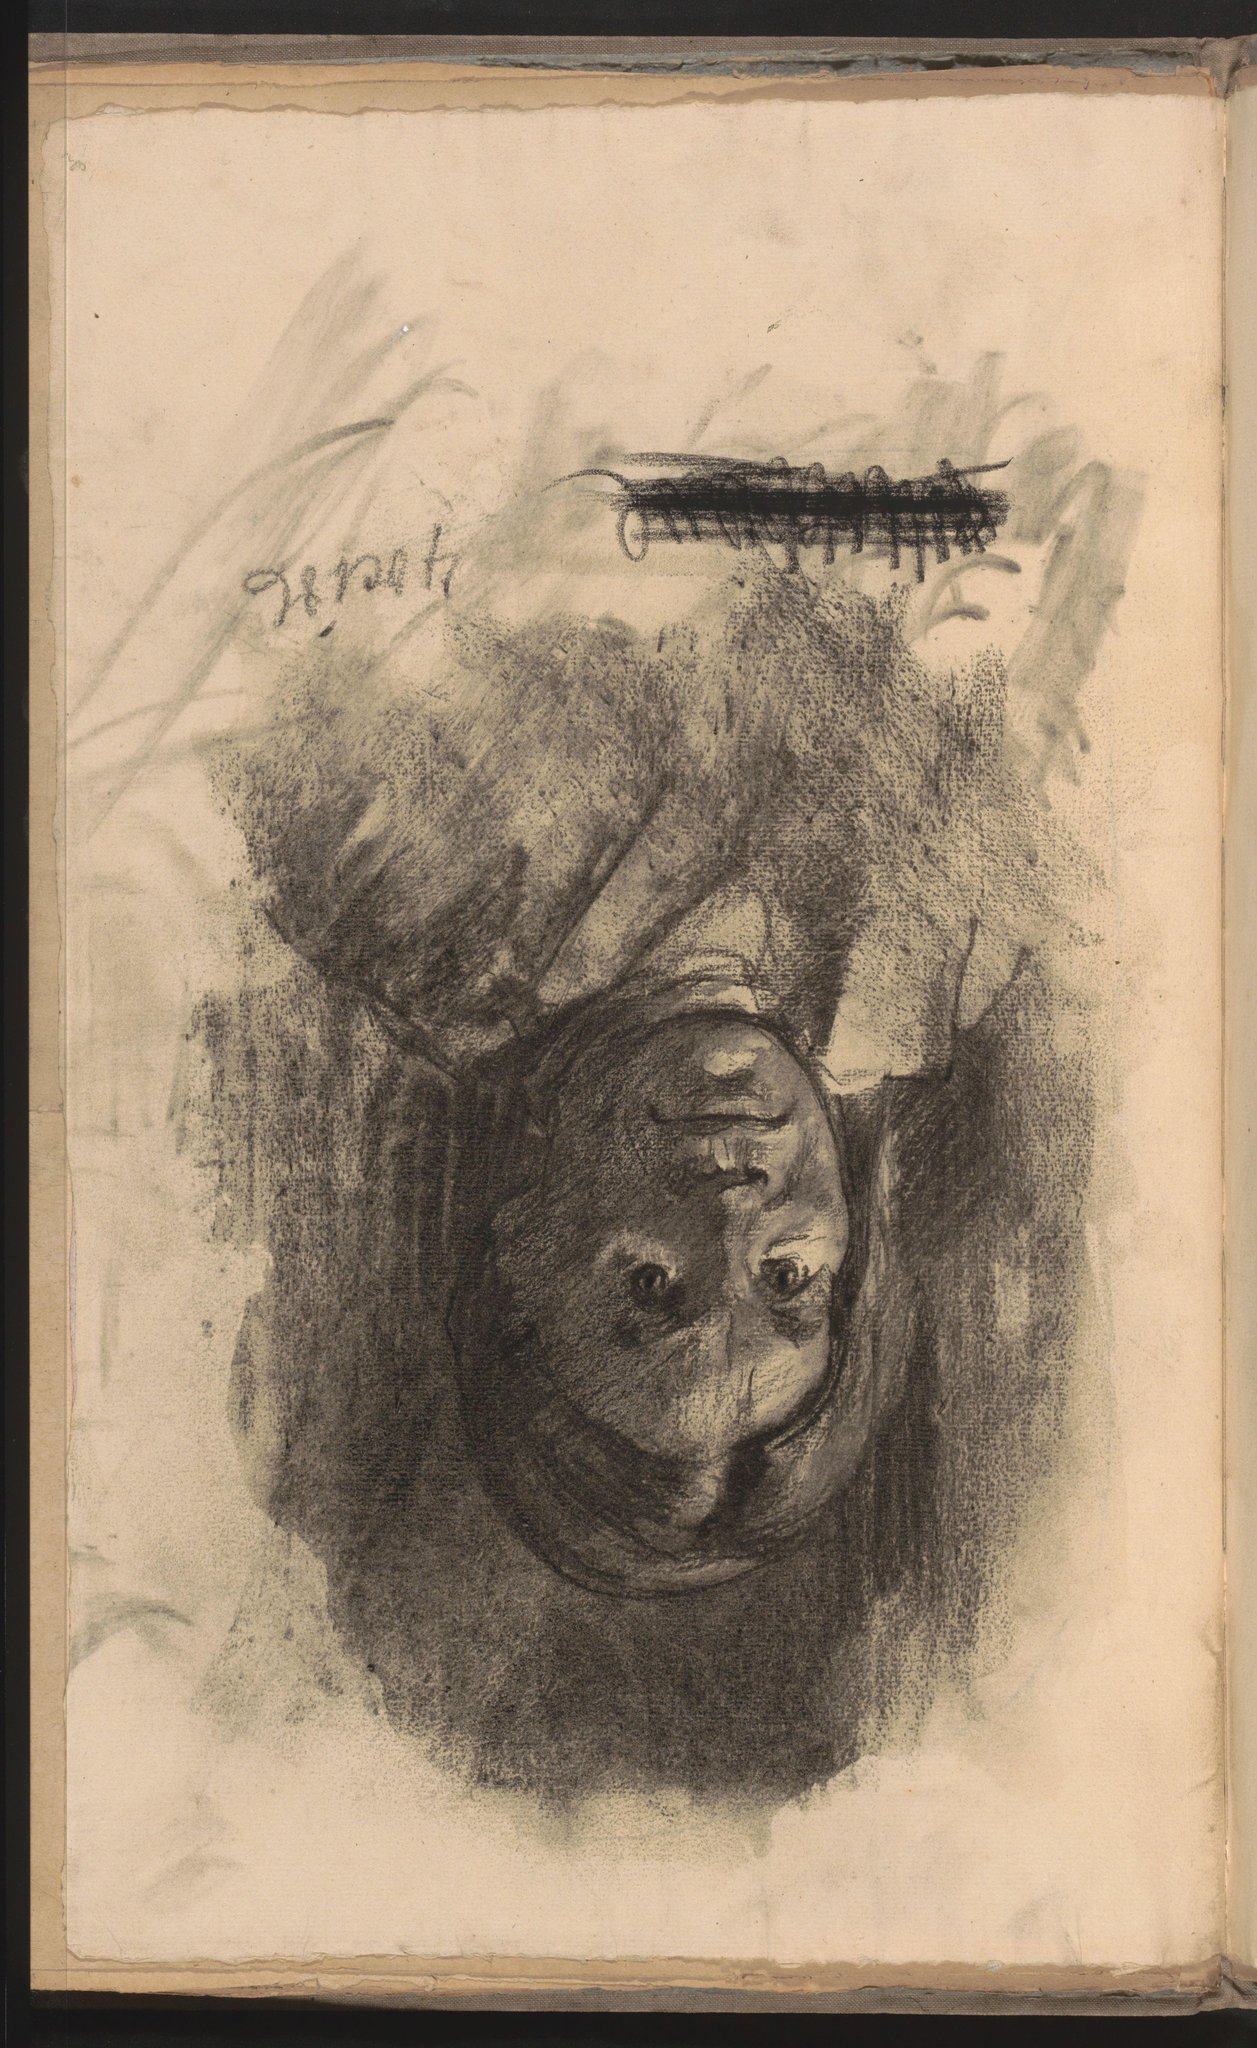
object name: sketchbook leaf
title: Buste van een vrouw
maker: willem witsen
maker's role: draughtsman, painter, print maker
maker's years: 1860-1923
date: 1886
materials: chalk, paper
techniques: stumping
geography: ewijkshoeve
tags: adult woman (+ front view)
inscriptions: date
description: Pagina 30 uit een schetsboek met 38 bladen betekend rond de Ewijkshoeve.